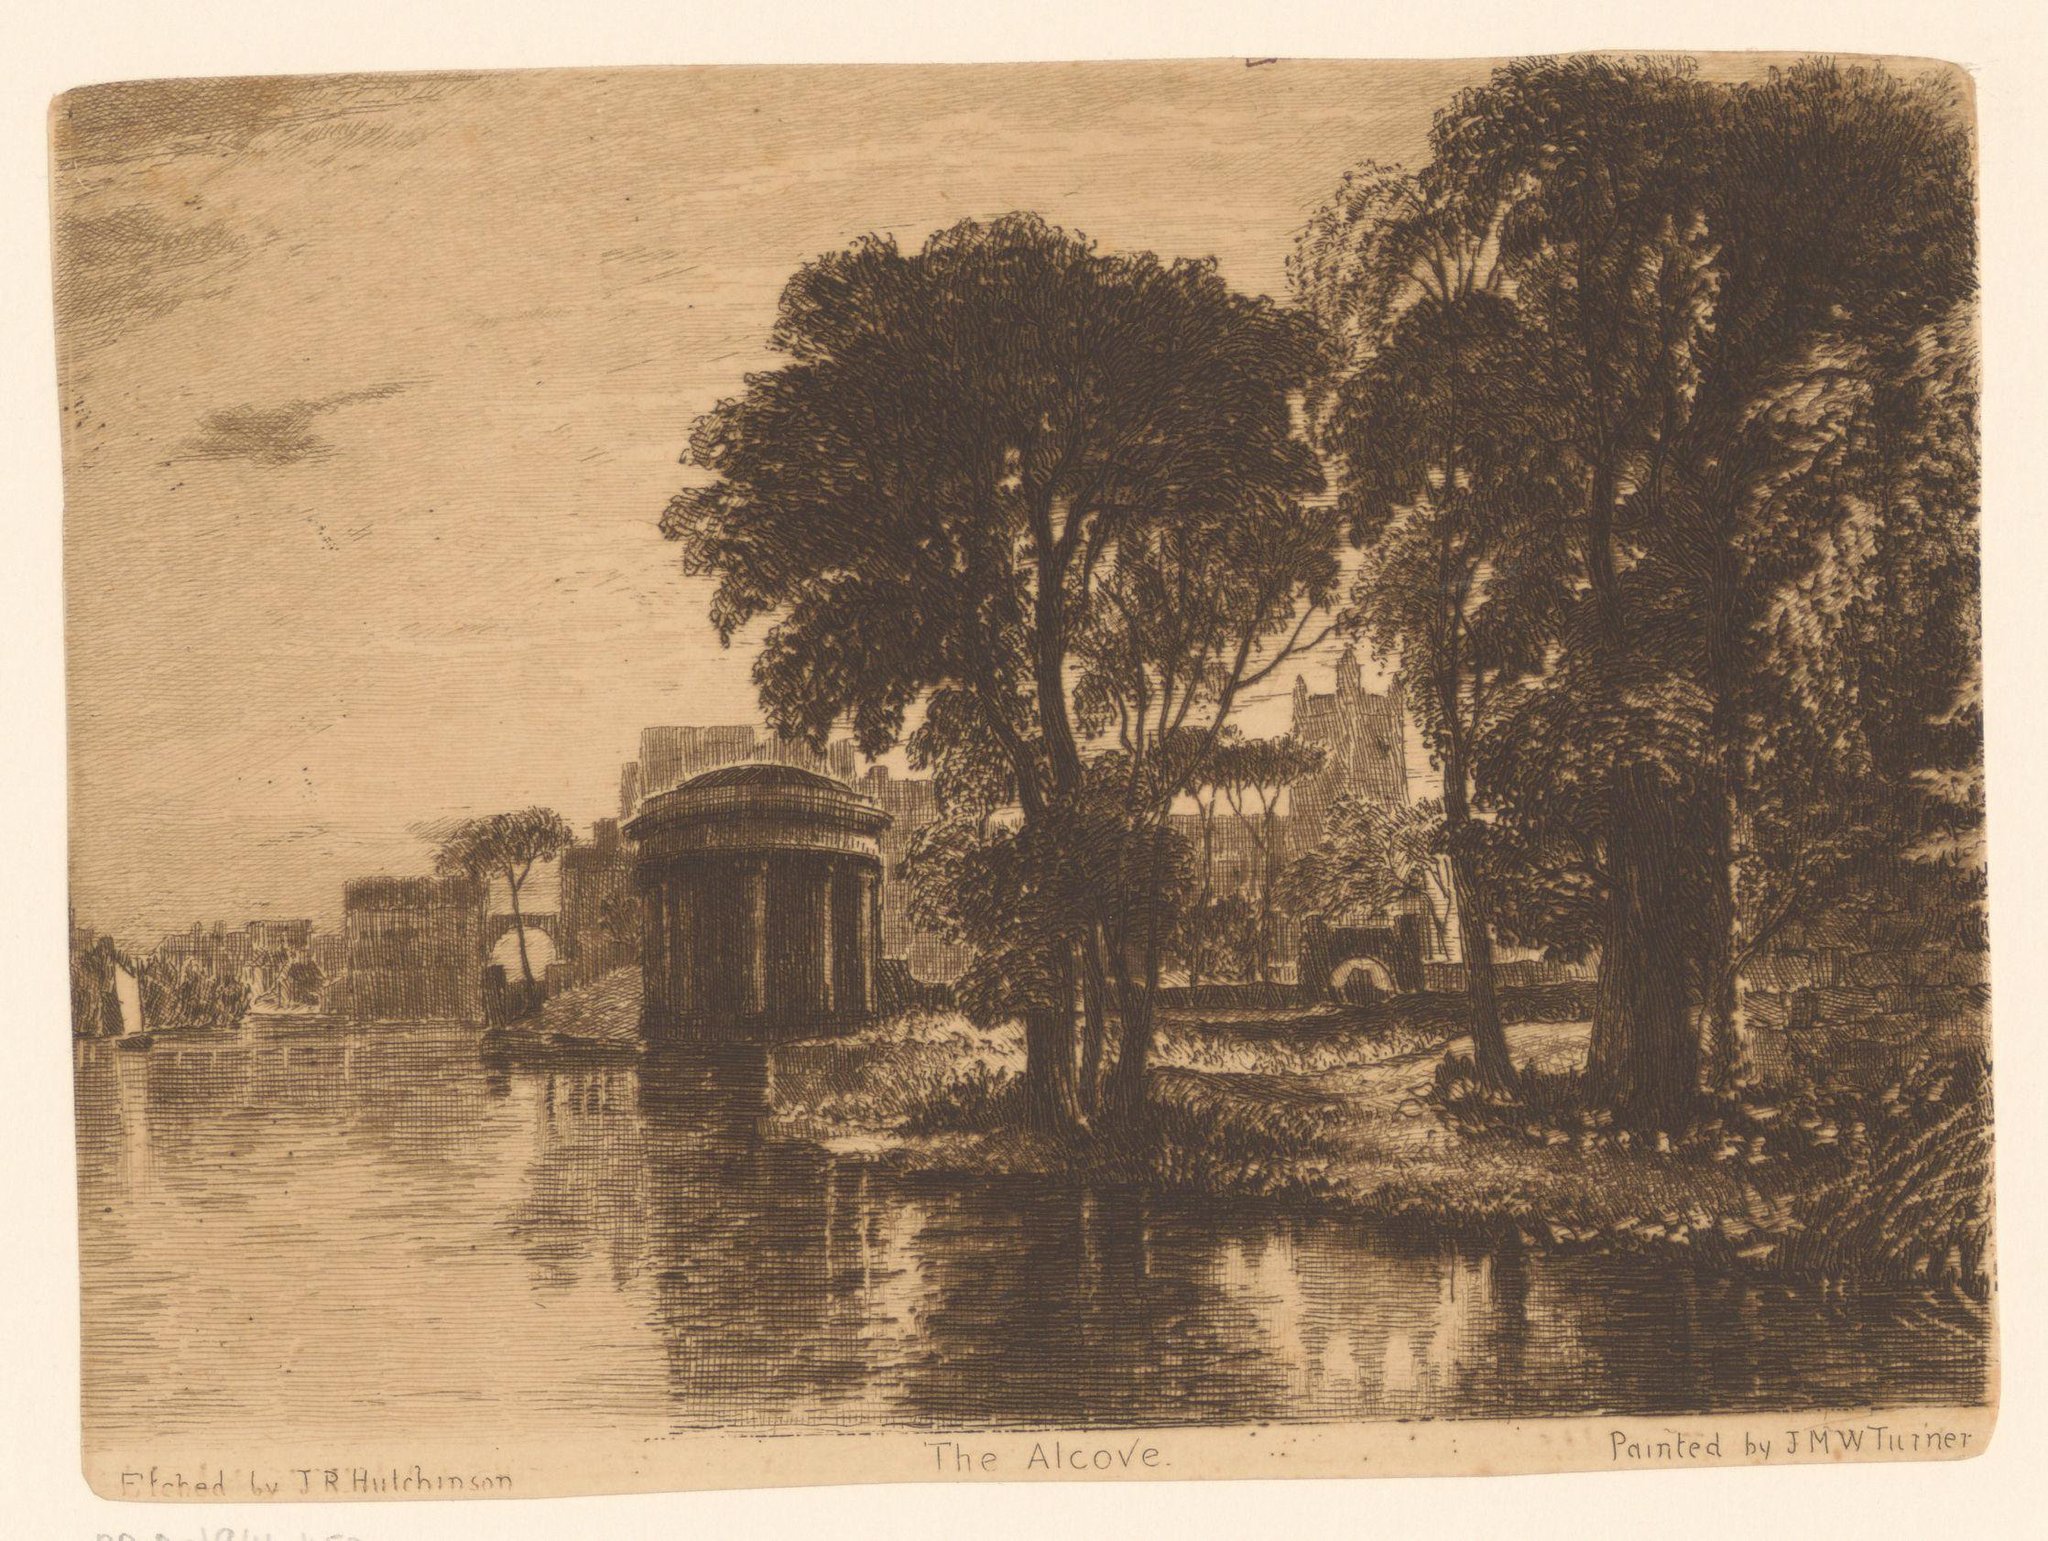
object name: print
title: The Alcove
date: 1800-1900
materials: paper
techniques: etching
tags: landscape with ruins (+ city(-scape) with figures, staffage)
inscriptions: collector's mark: Lugt 2228